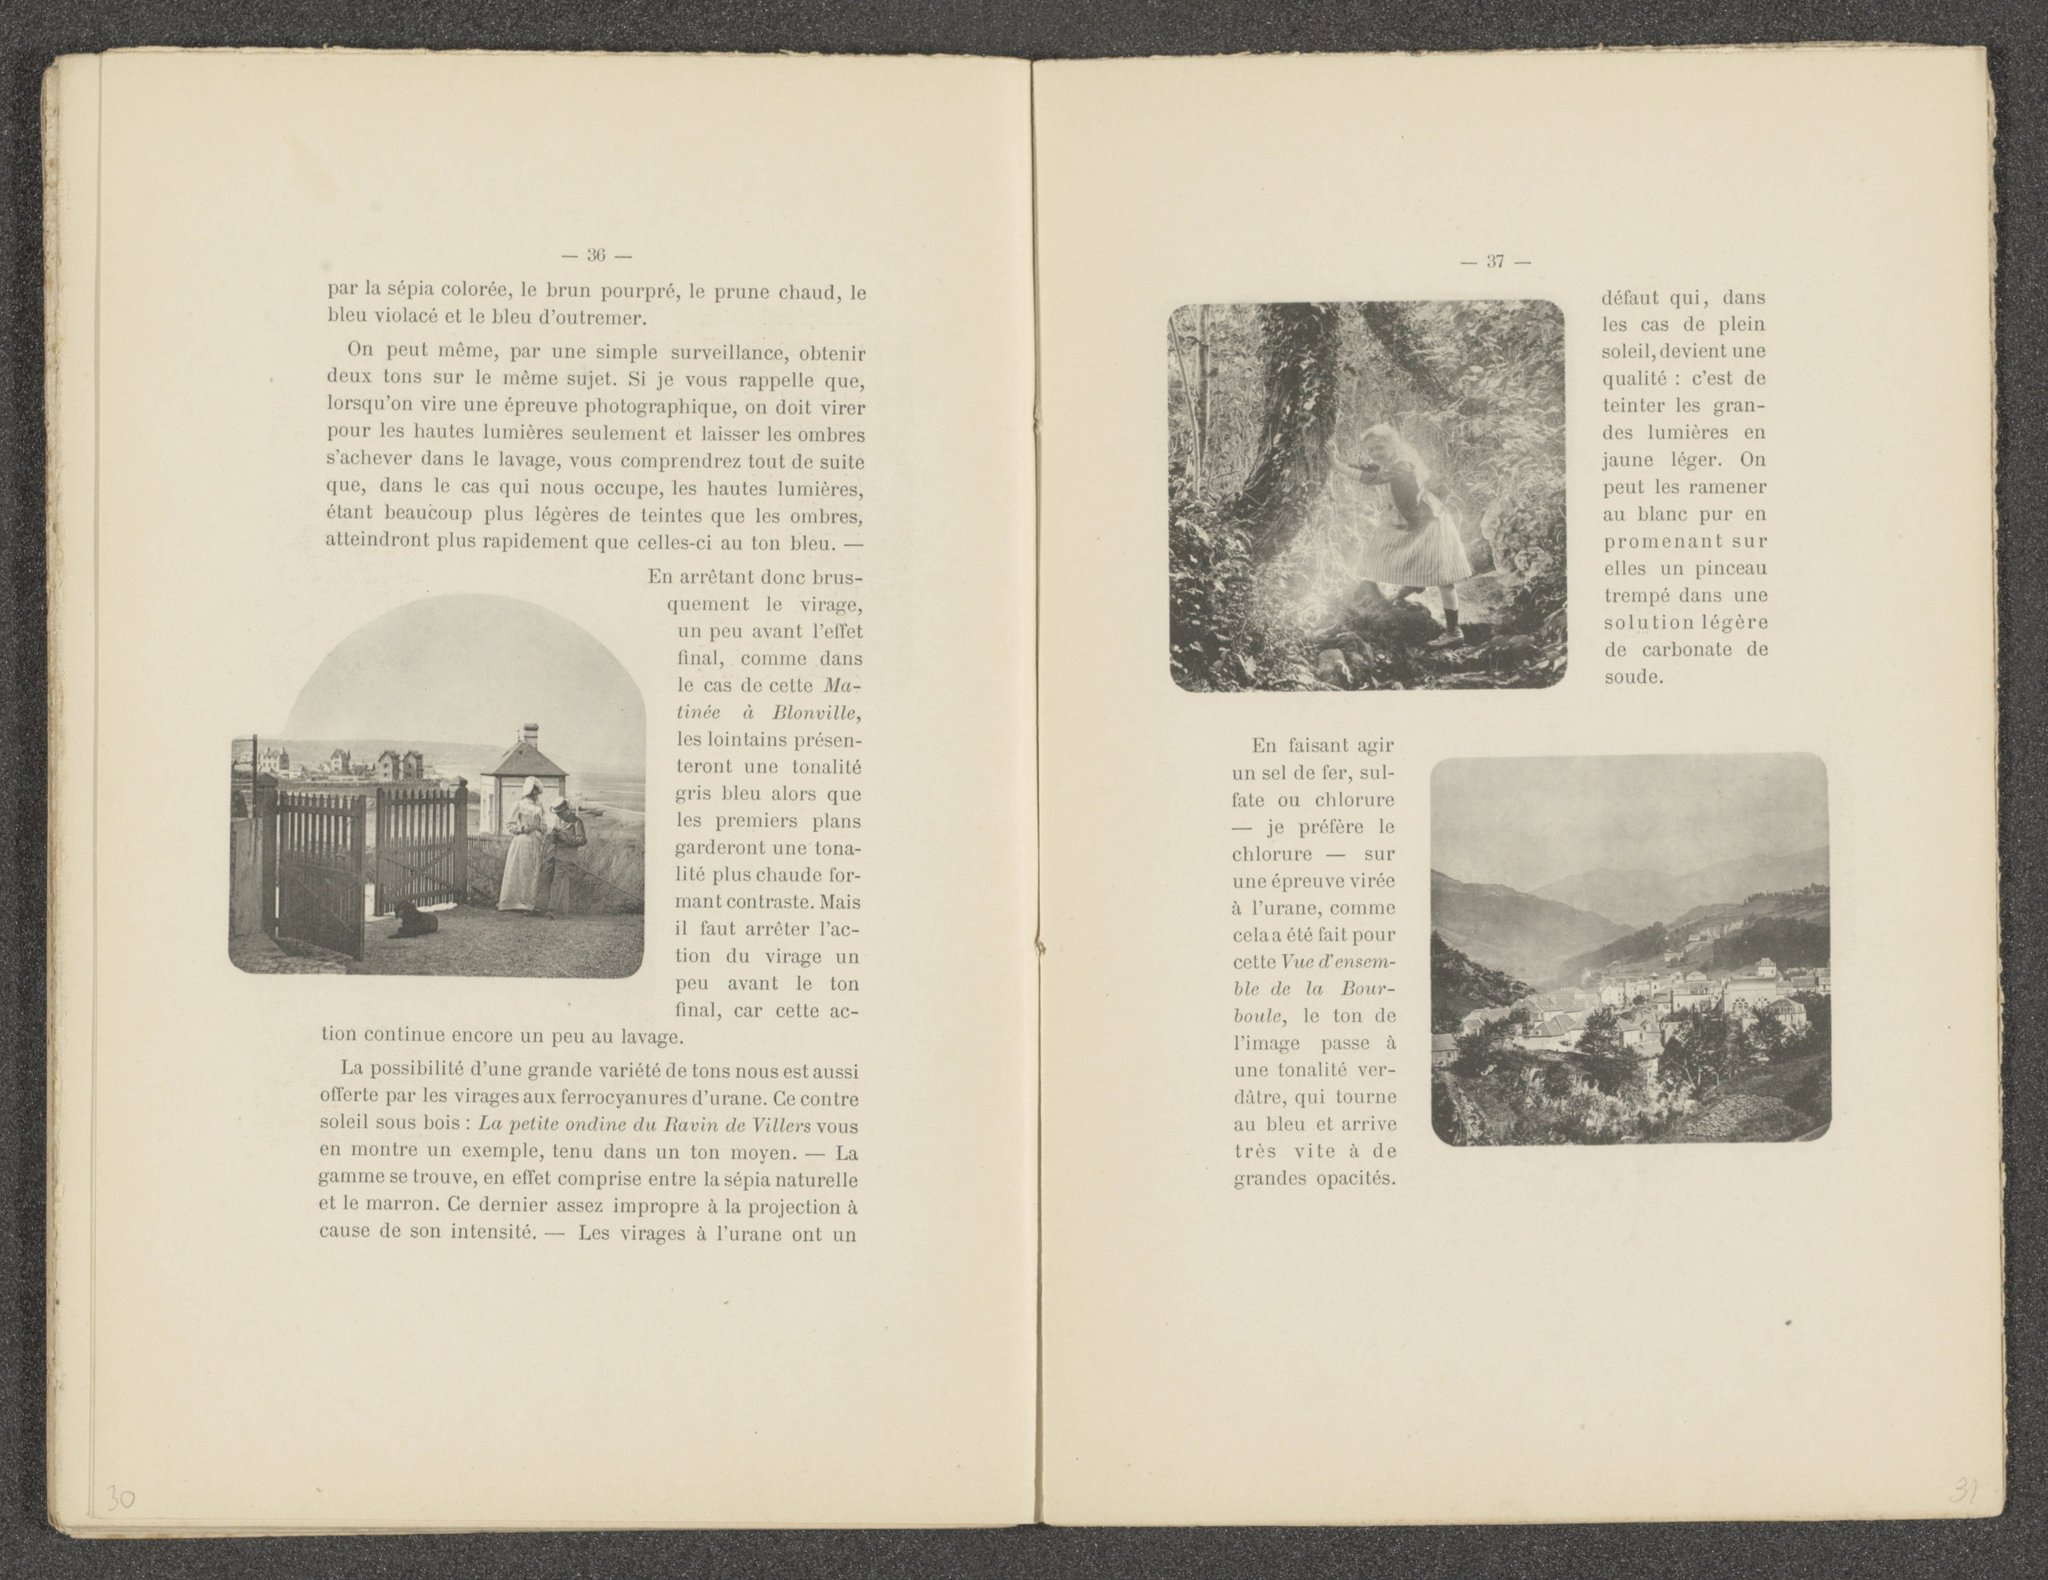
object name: page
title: Man en een vrouw voor een hek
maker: Anonymous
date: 1886-1896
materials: paper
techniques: photograph, printing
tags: adult woman, fence, wall, paling, adult man